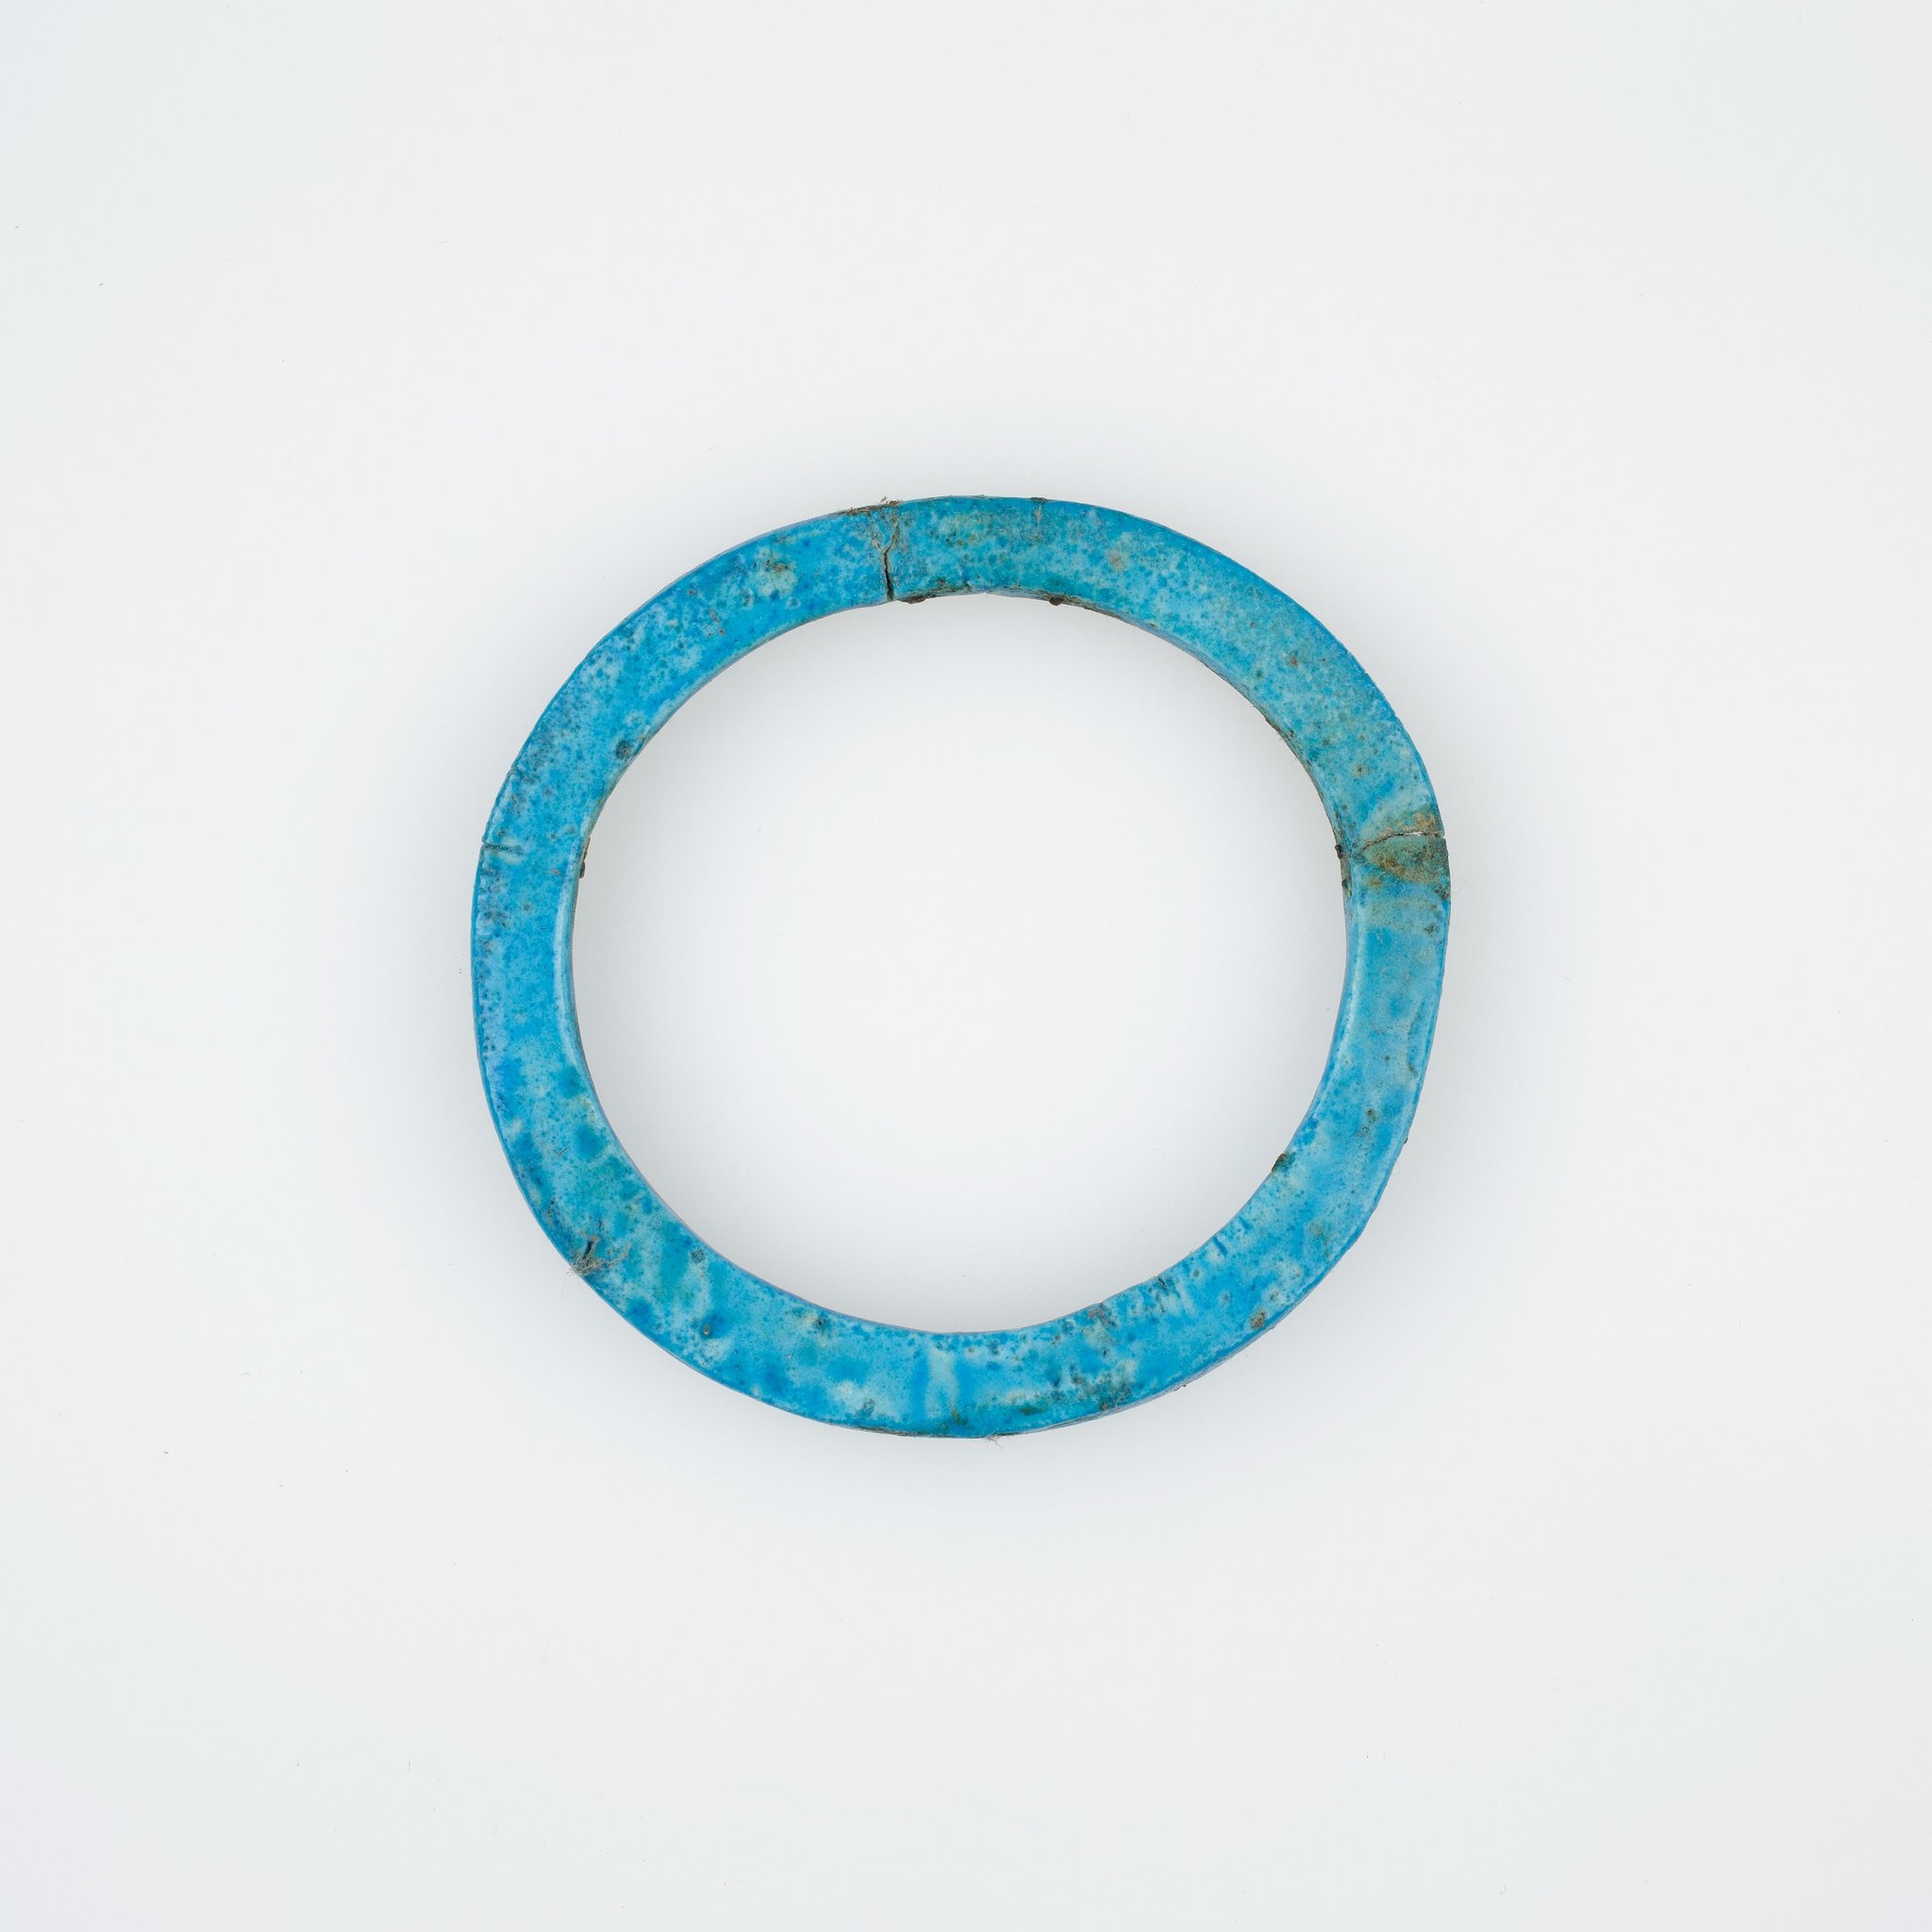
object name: armlet, a'a, amenhotep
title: Armlet of Amenhotep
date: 1479-1458 BCE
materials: faience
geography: egypt